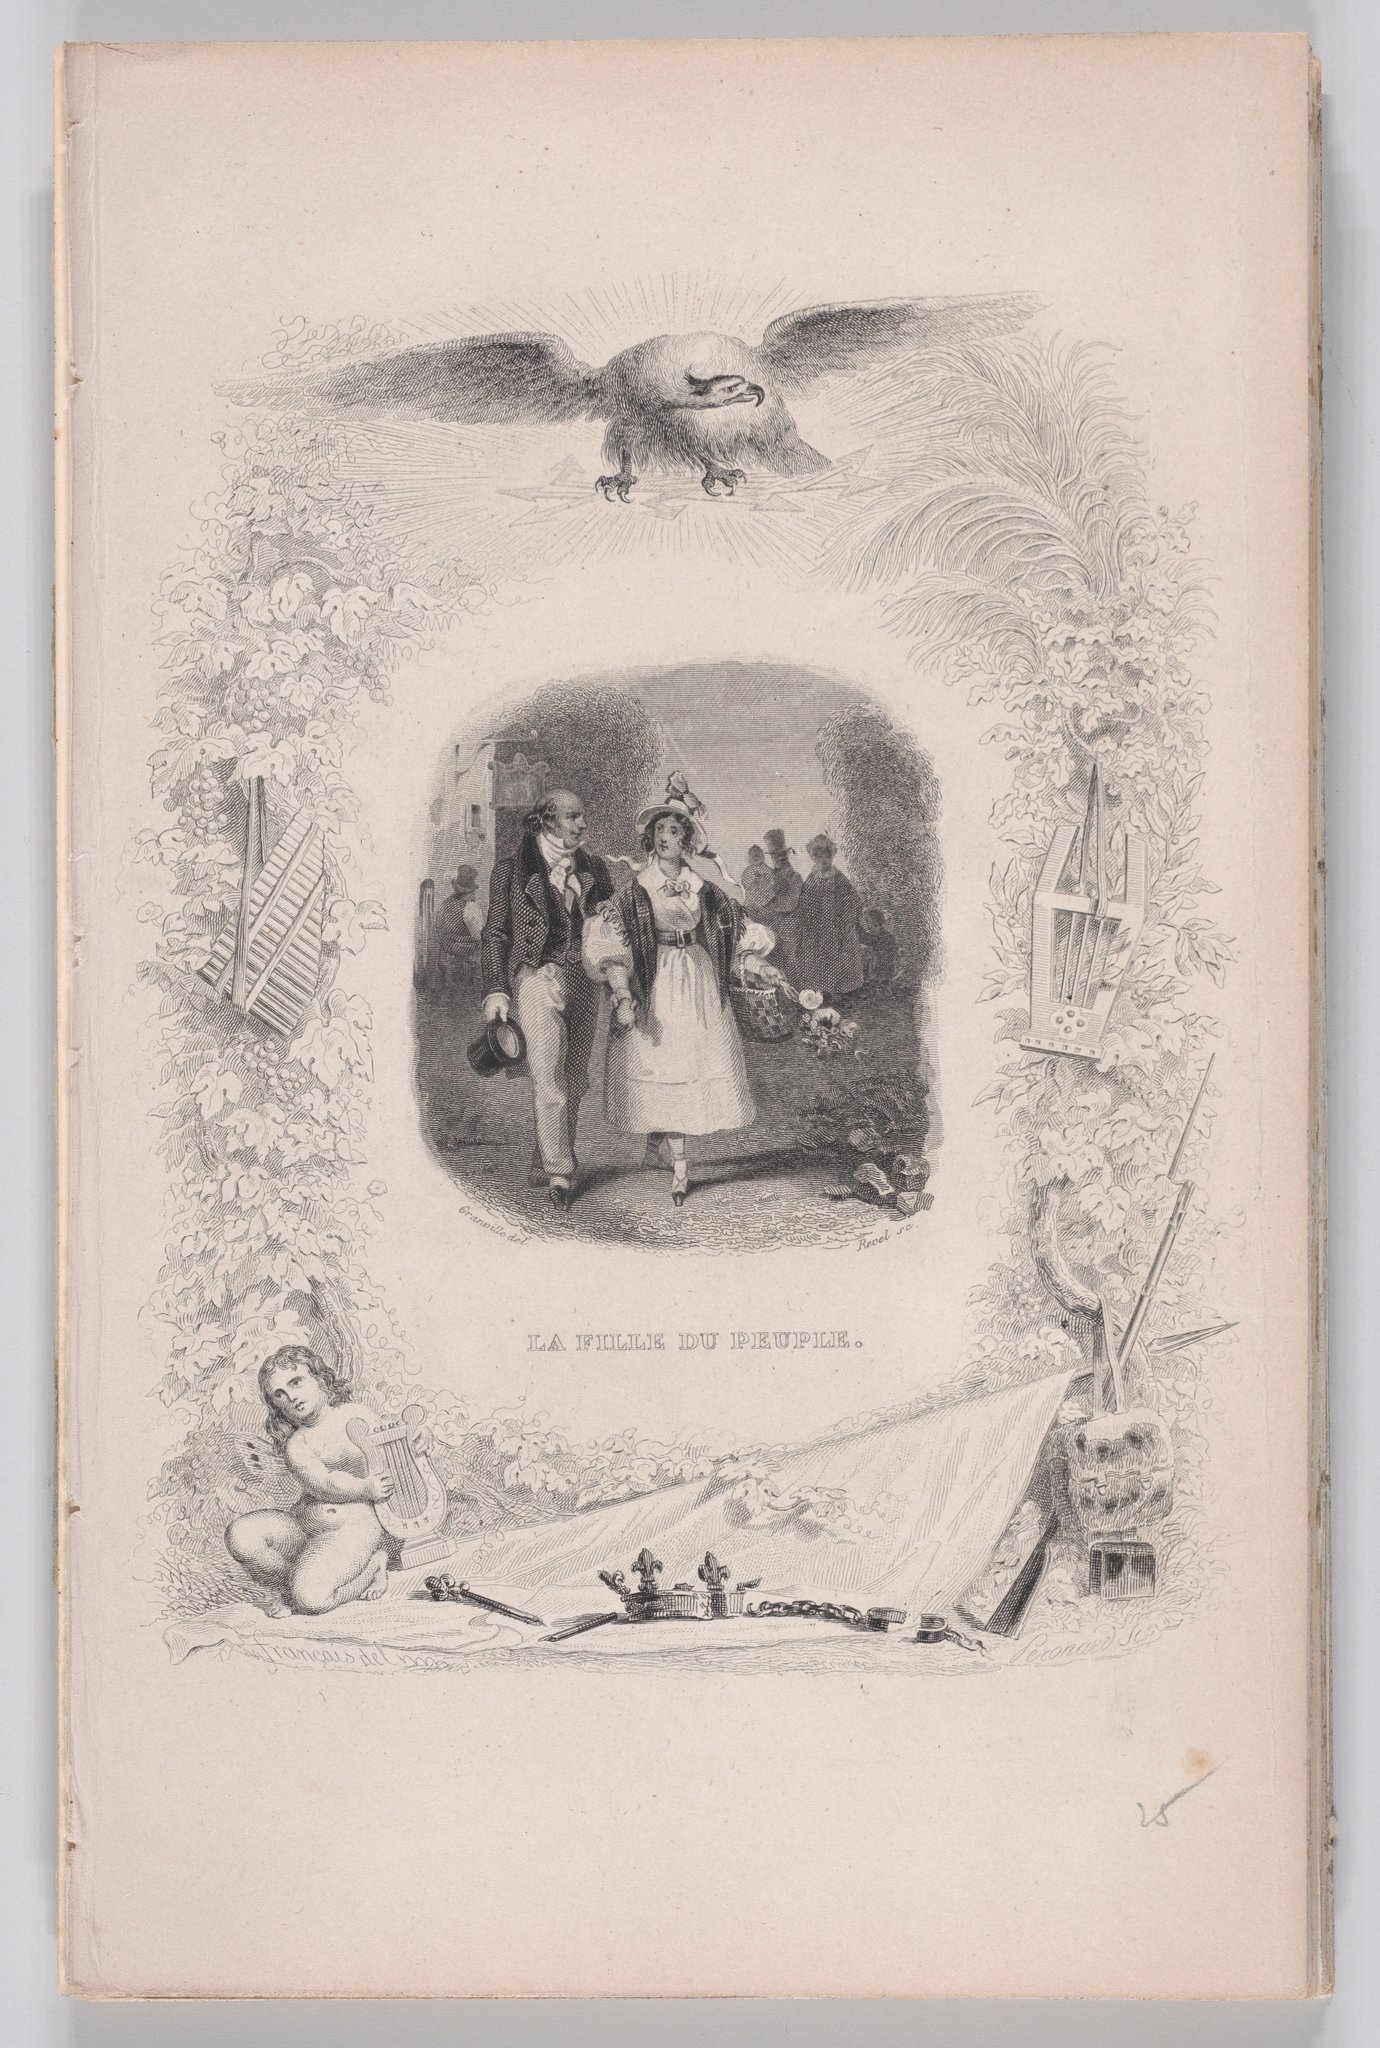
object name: print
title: Daughter of the People, from "The Songs of Béranger"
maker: j. j. grandville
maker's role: designer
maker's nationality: french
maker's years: 1803-1847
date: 1829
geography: paris